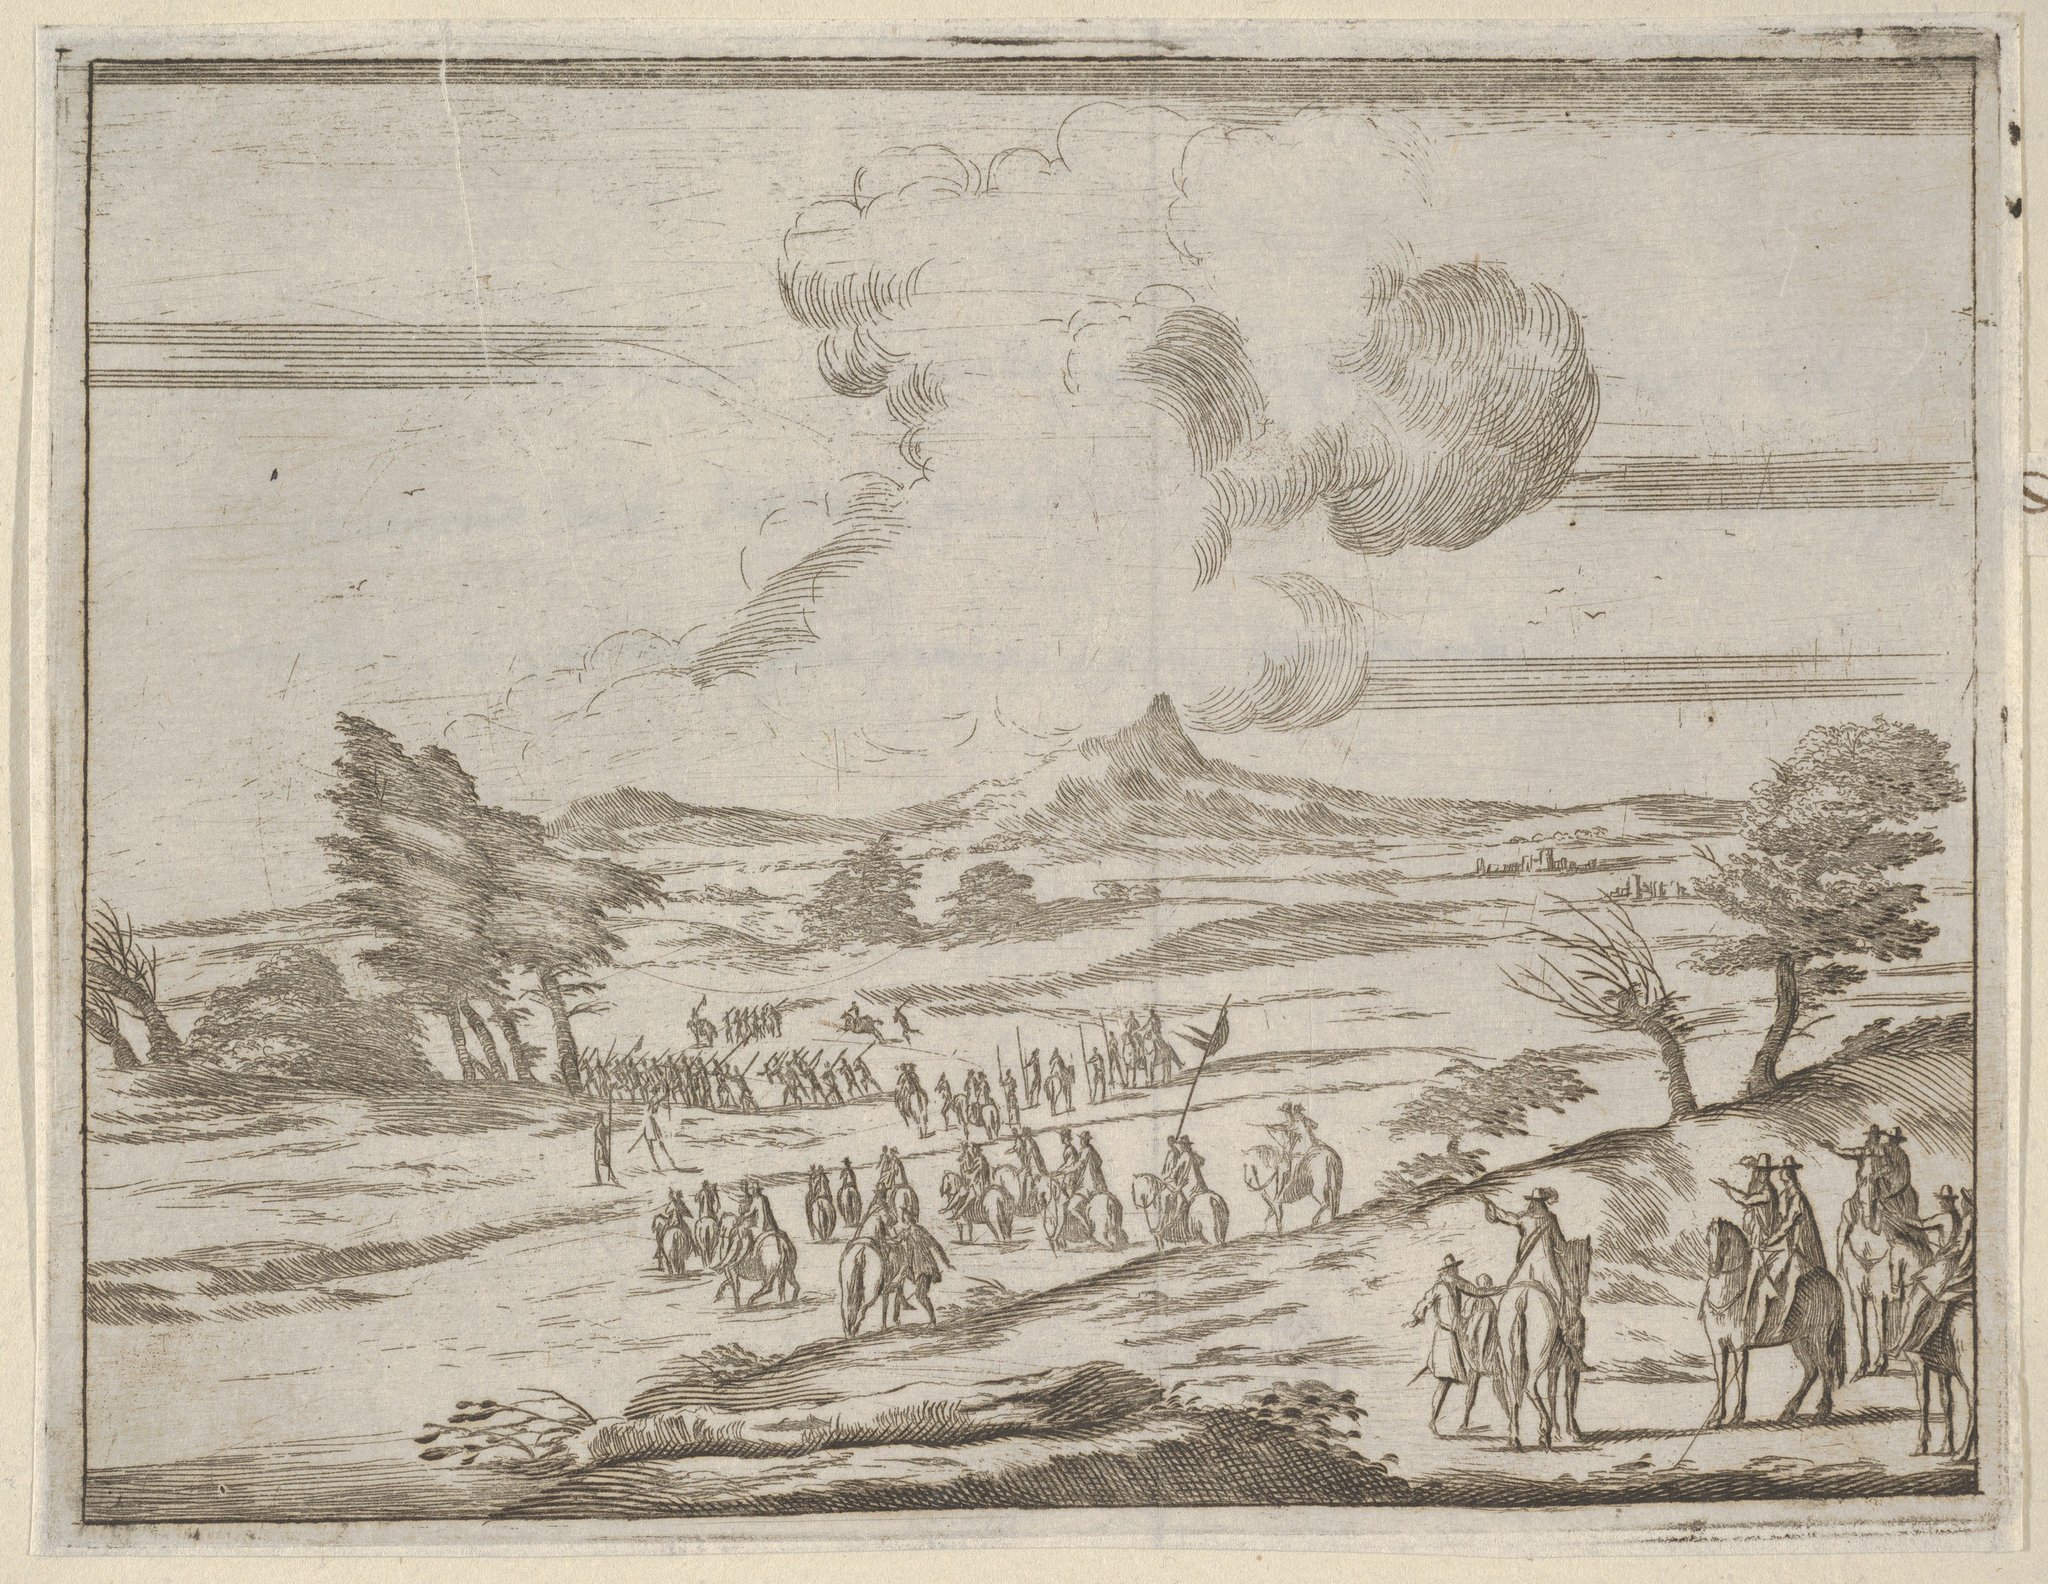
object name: print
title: Following Francesco I d'Este's Example, His Troops Safely Pass Torrents During Extreme Weather, from "L'Idea di un Principe ed Eroe Cristiano in Francesco I d'Este, di Modena e Reggio Duca VIII [...]"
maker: bartolomeo fenice (fénis)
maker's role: artist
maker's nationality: italian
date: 1659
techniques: etching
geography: italy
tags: soldiers,men,horses